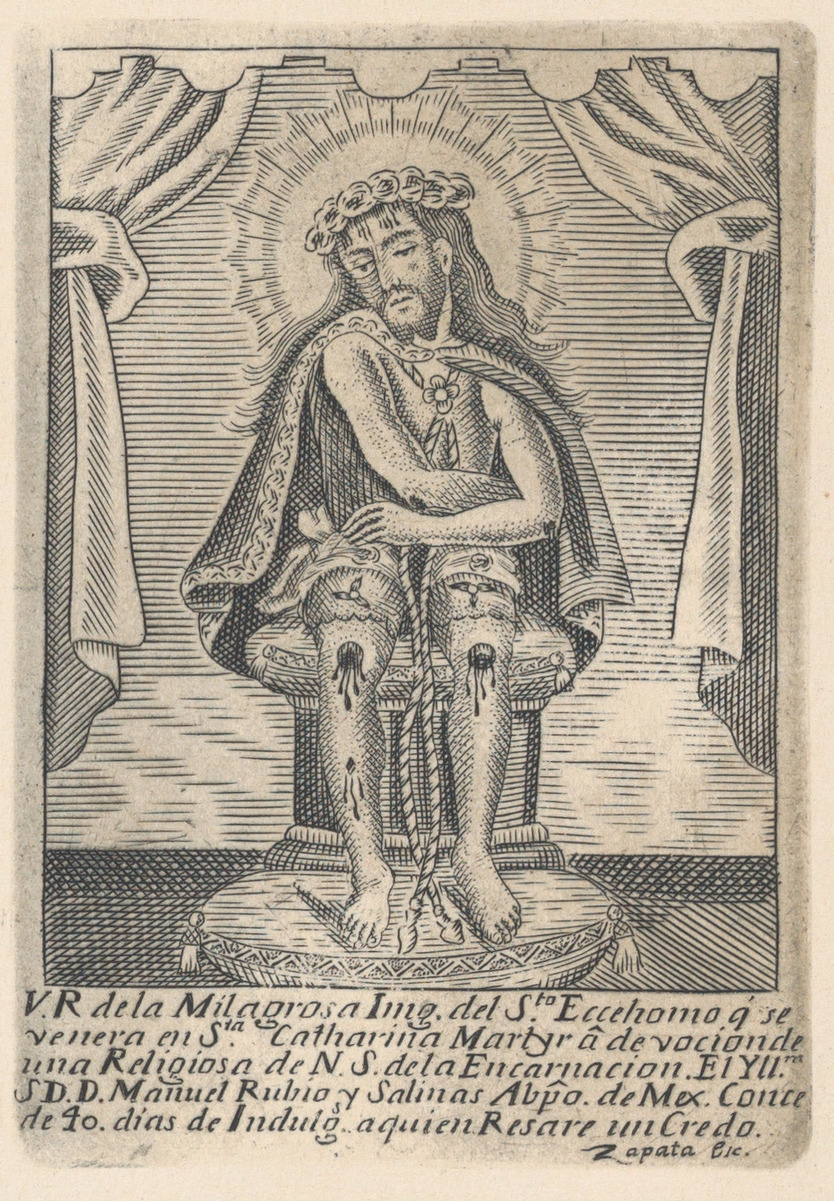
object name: print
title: 'Ecce Homo' Christ seated, crowned, his wounds showing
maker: anonymous, mexican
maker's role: artist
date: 1750-1765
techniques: engraving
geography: mexico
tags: suffering,christ